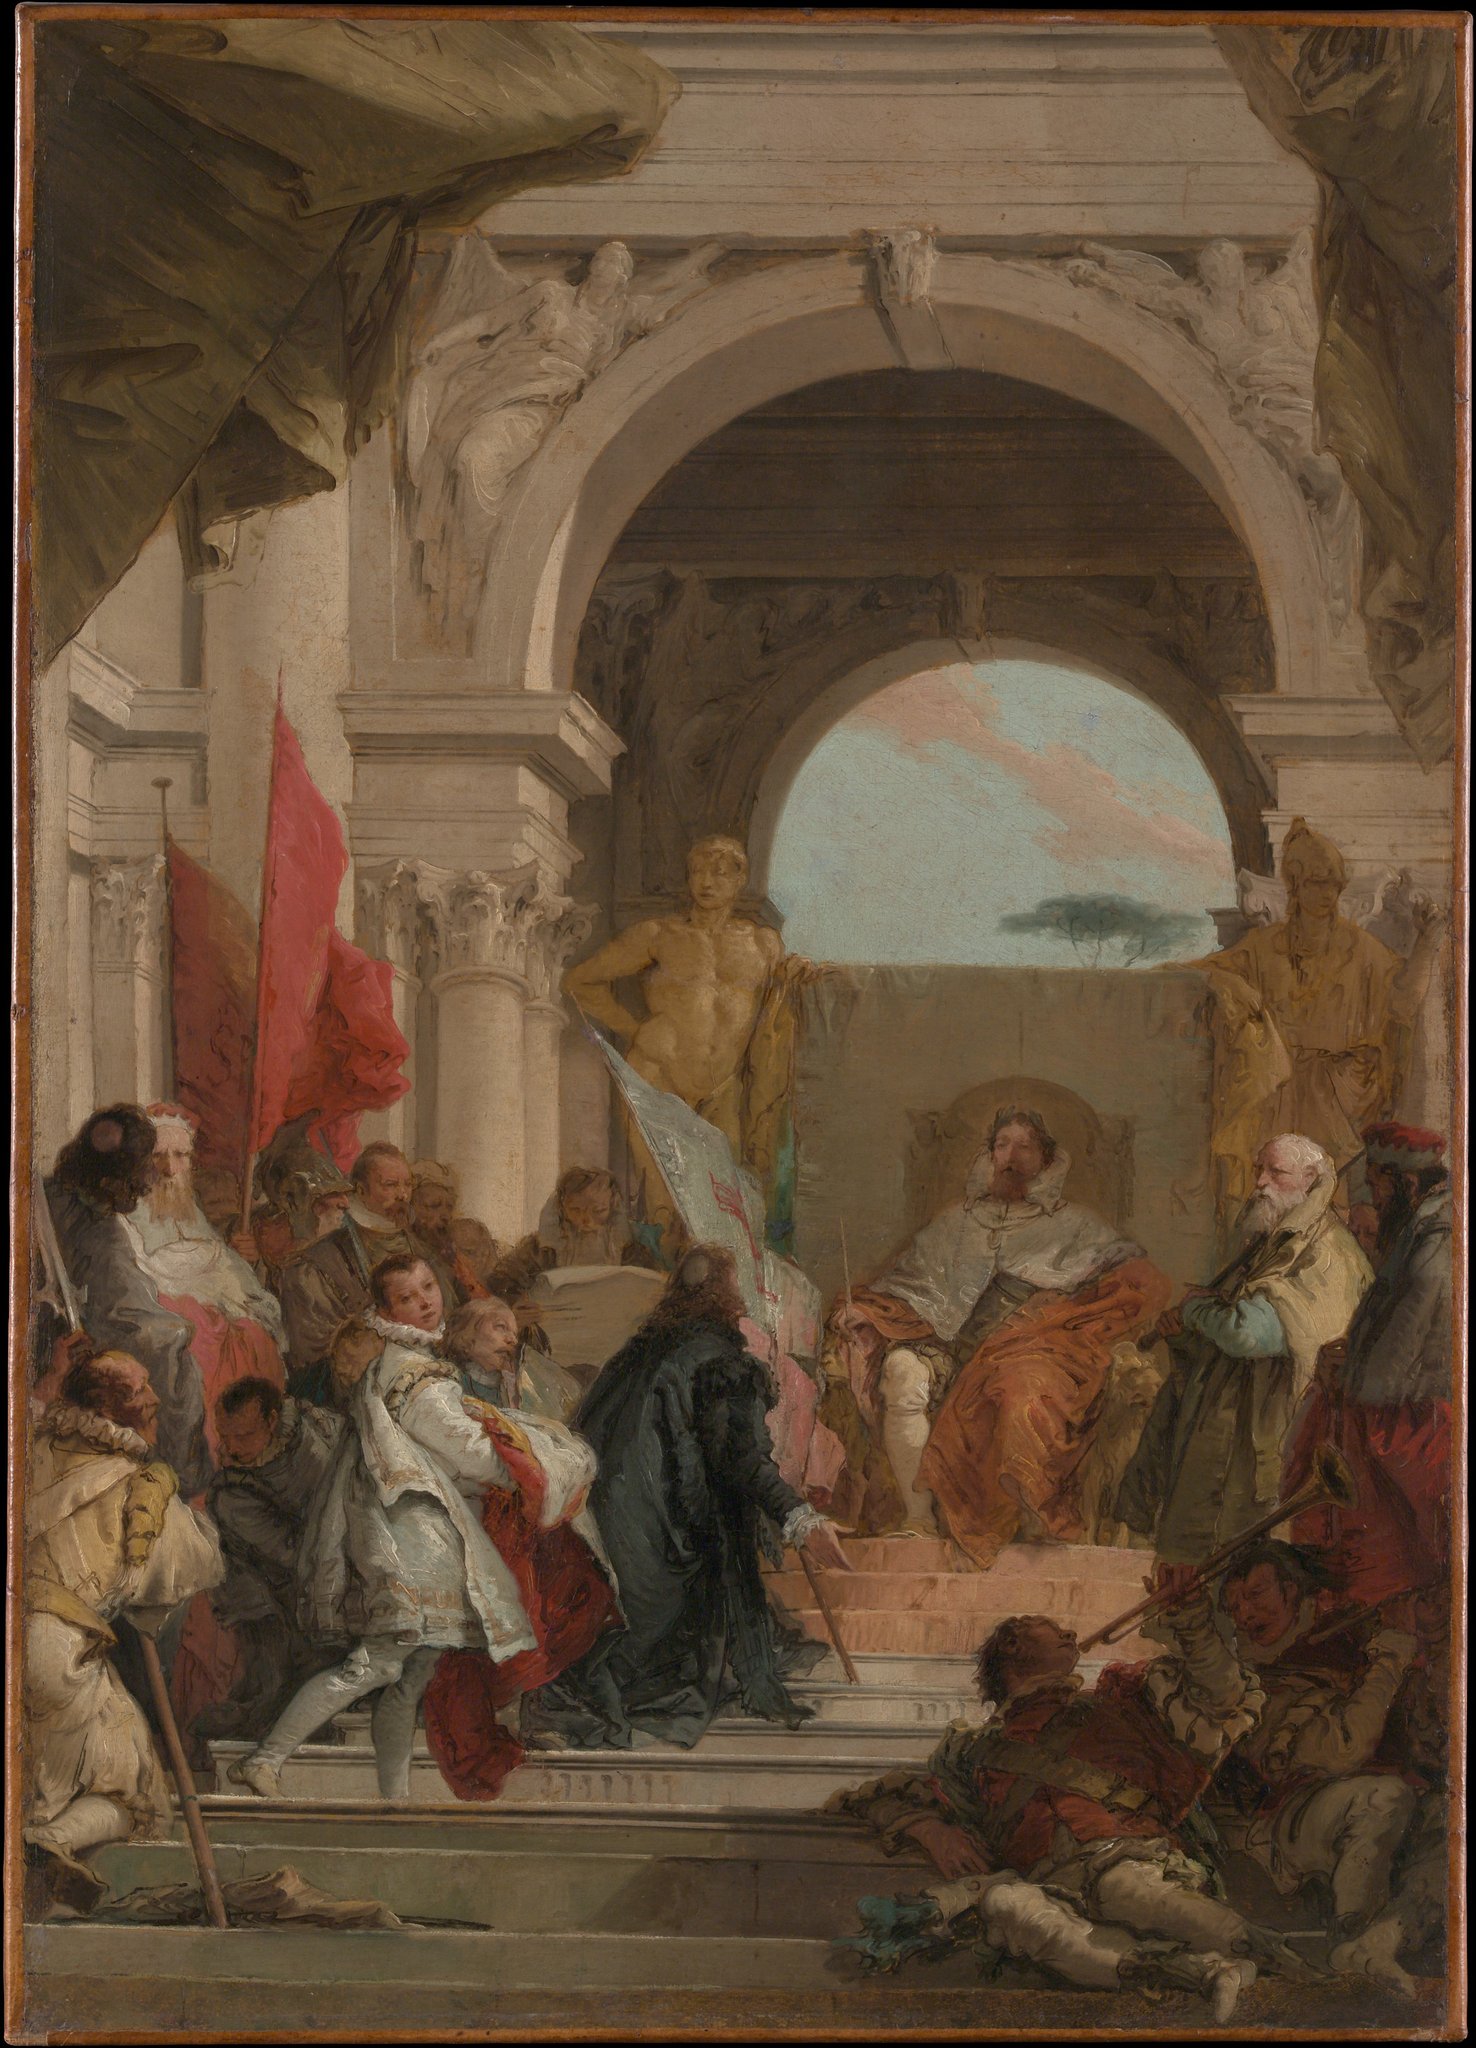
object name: painting, sketch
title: The Investiture of Bishop Harold as Duke of Franconia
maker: giovanni battista tiepolo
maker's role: artist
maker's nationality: italian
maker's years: 1696-1770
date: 1751-1752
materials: canvas, oil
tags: musical instruments,arches,men,bishops